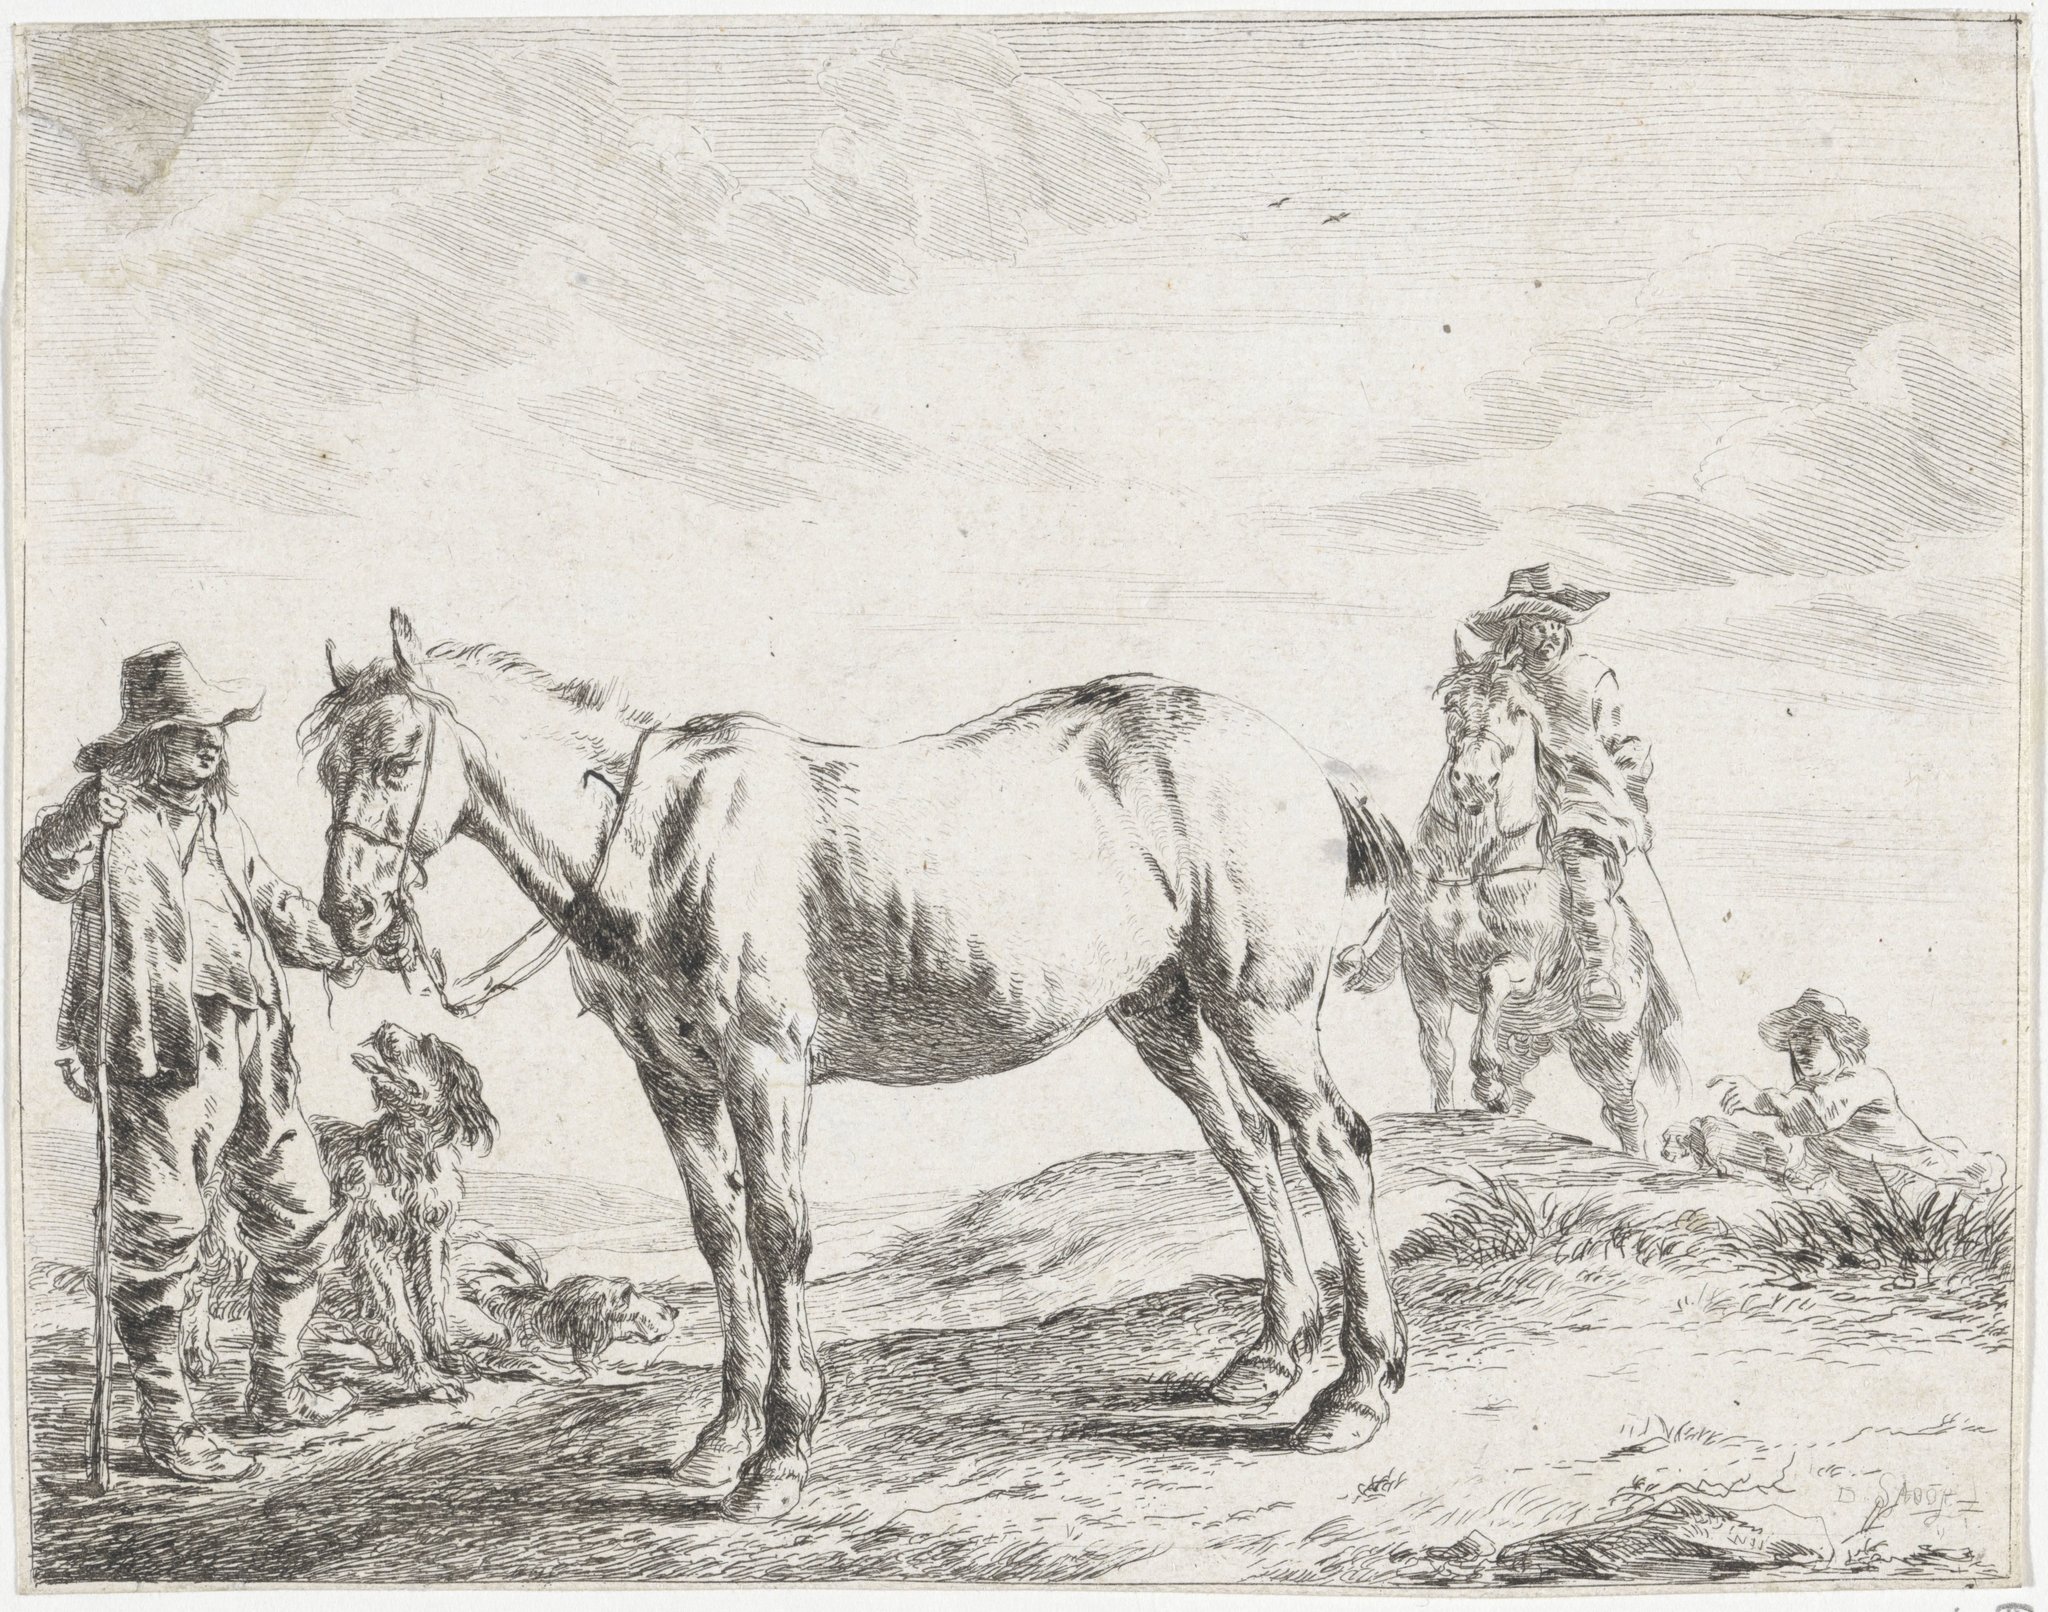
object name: print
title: Paarden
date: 1651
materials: paper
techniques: etching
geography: amsterdam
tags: horse, dog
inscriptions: collector's mark: Lugt 2228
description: Een man houdt een paard bij de teugels. Naast hem twee honden. Rechts een ruiter en een wijzende man.